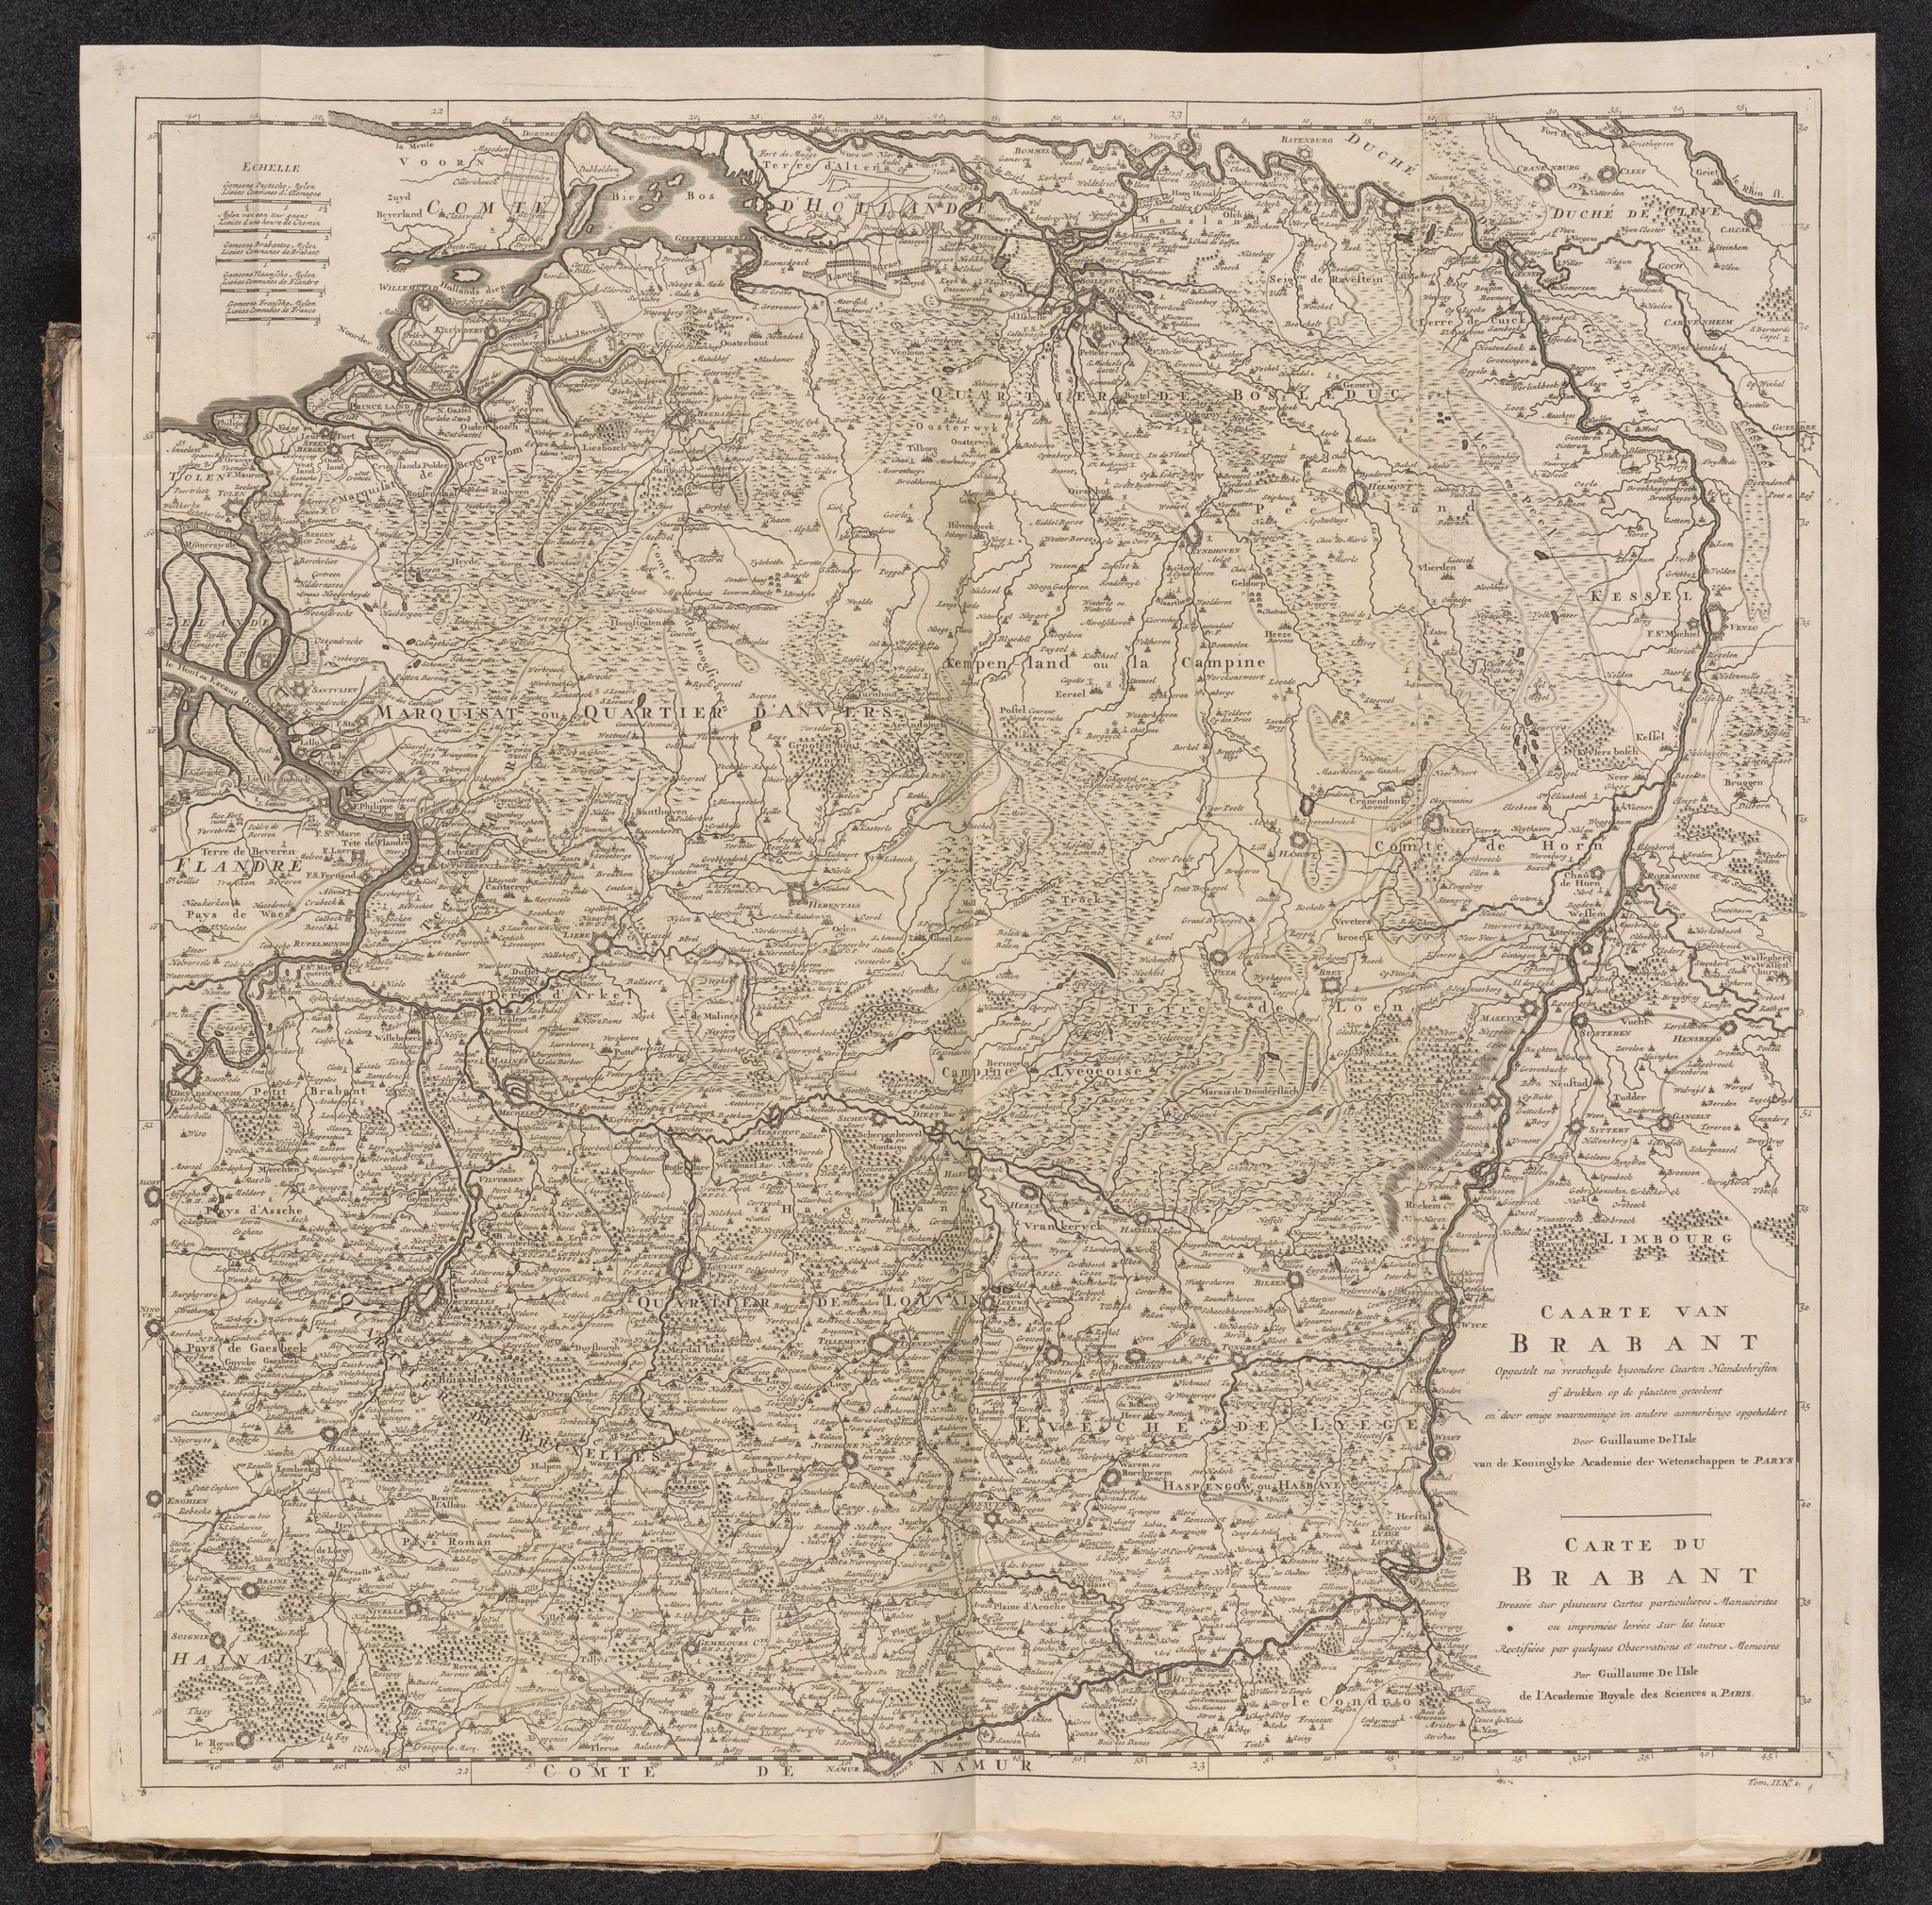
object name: print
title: Caarte van Brabant Opgestelt na verscheyde bysondere Caarten Handschriften of drukken op de plaatsen geteekent (...) / Carte du Brabant (...)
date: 1680-1710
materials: paper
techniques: engraving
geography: northern netherlands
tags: johan willem friso (prins van oranje-nassau), john churchill (1e hertog van marlborough), maps of separate countries or regions, brabant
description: Kaart van Brabant, ca. 1701-1713. Genummerd rechtsonder: Tom. II. No. 1. Illustratie in het tweede deel van : [Jean] du Mont, Oorlogskundige beschryving van de veldslagen en belegeringen, der drie ... wydvermaarde krygsoversten... den Prins Eugenius van Savoye, den ... Hertog van Marlborough, en den Prins van Oranje en Nassau-Vriesland, in de editie van 1729. Dit tweede deel is hoofdzakelijk gewijd aan de daden van de hertog van Marlborough en prins Johan Willem Friso.